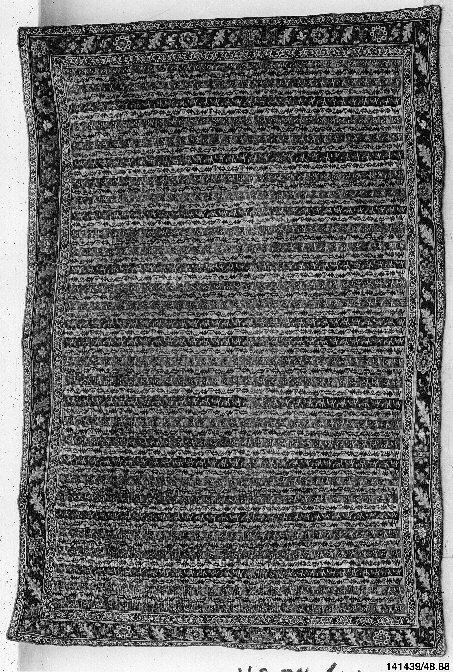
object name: carpet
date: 1801-1833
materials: wool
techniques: stitching, weave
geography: caucasus